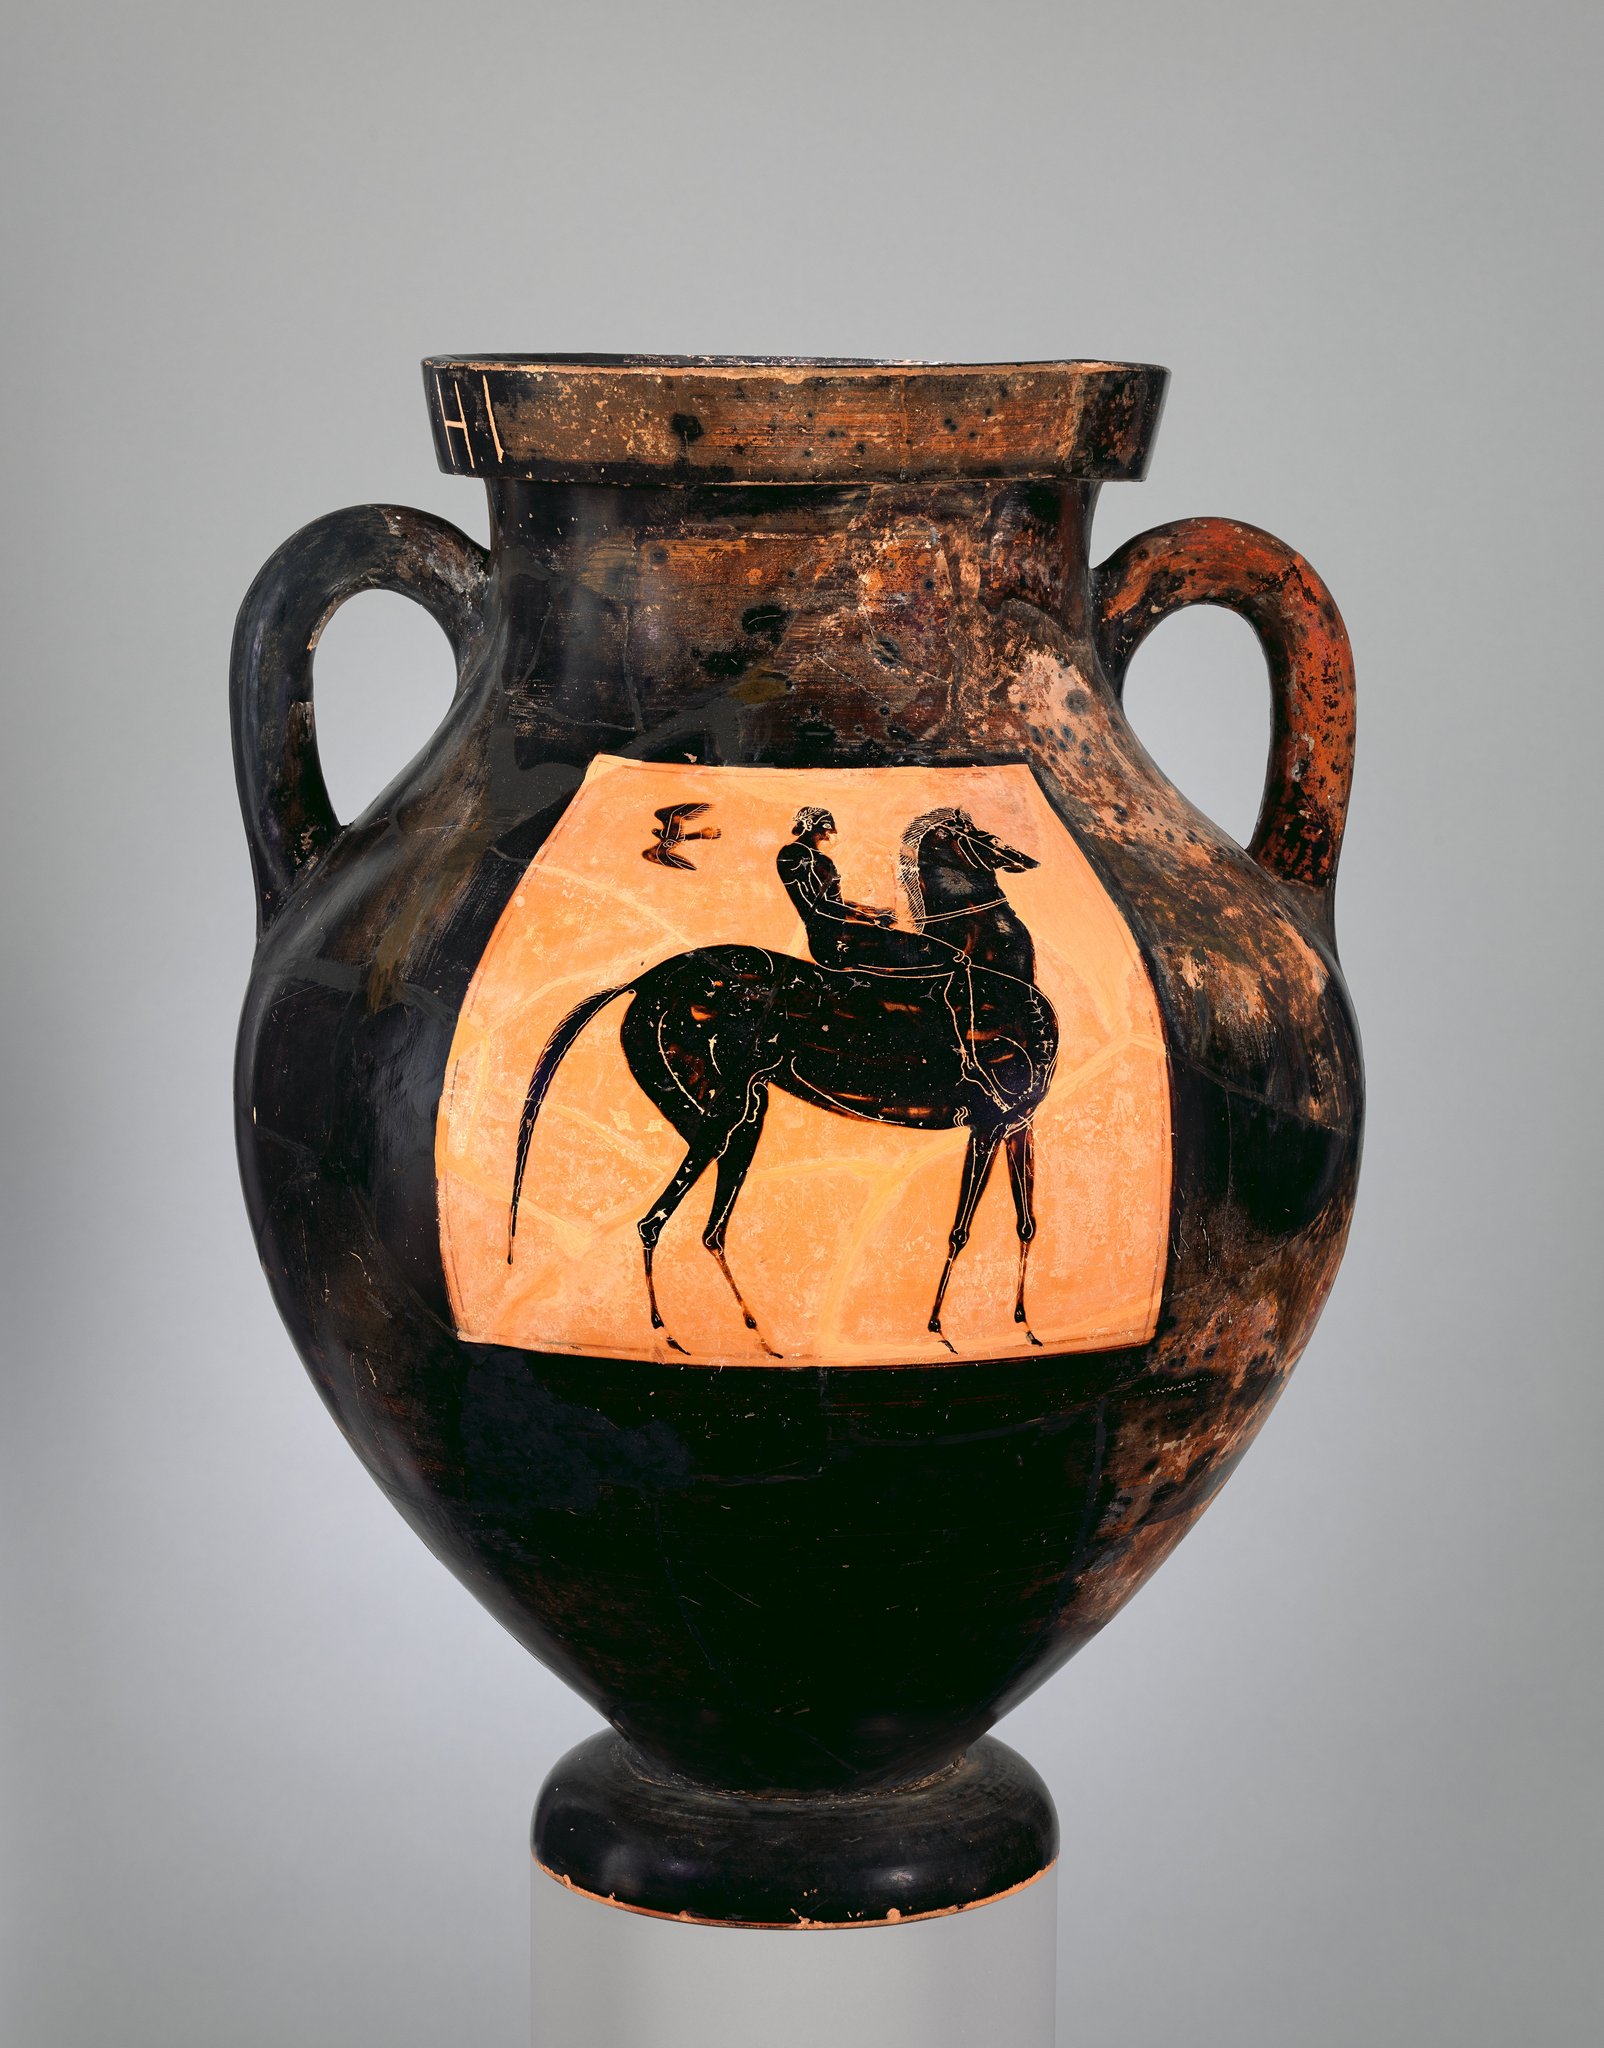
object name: amphora, type b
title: Terracotta amphora (jar)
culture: greek, attic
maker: lydos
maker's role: artist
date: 540 BCE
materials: terracotta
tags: men,horses